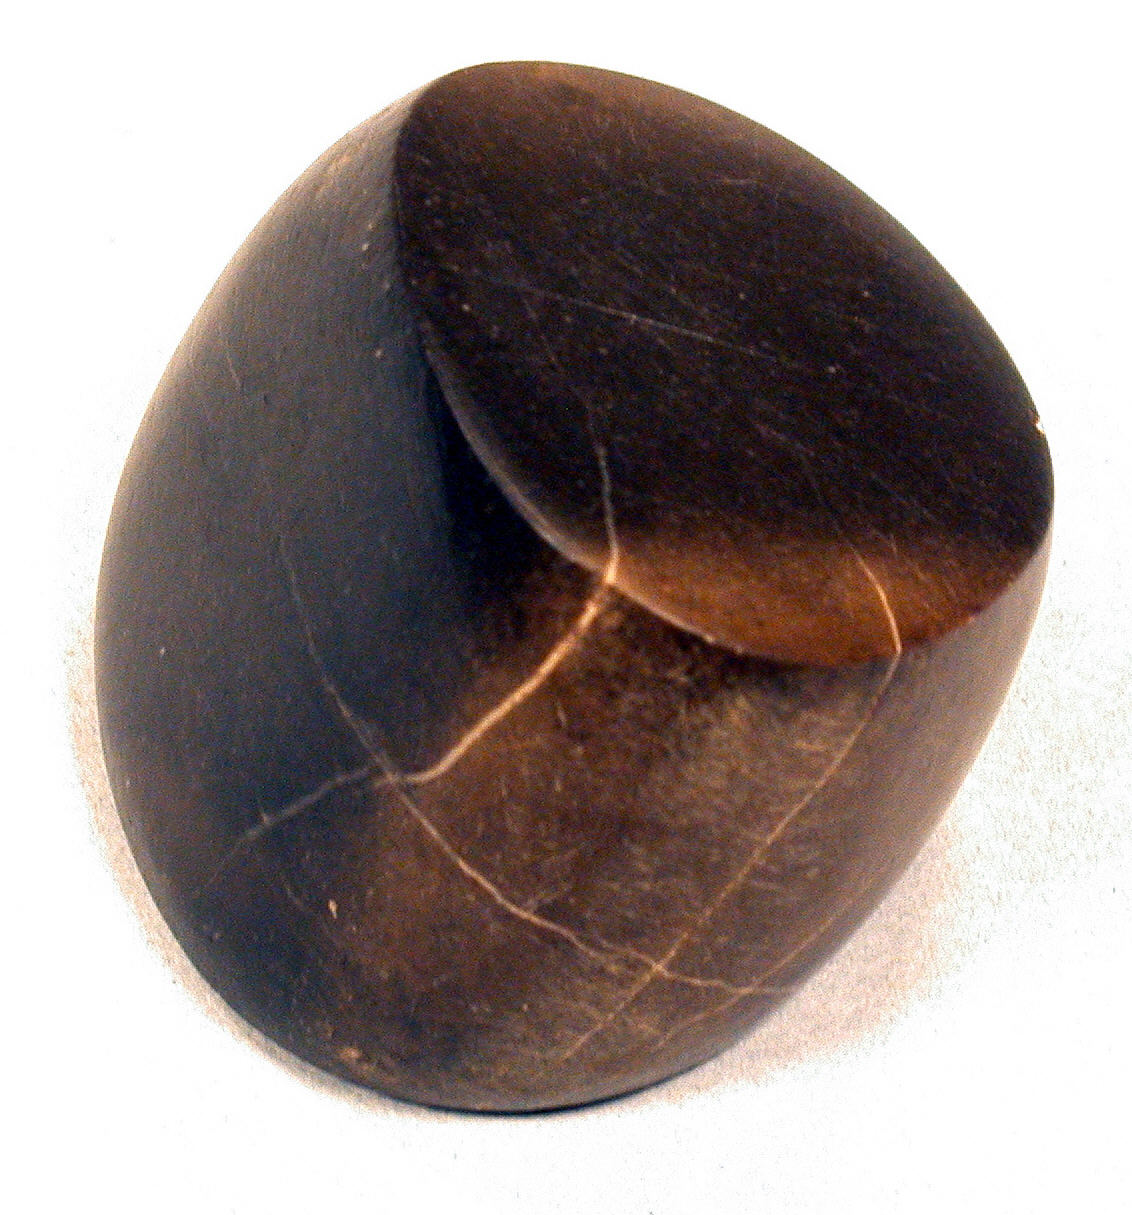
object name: ritual stone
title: Pulidor (polishing stone)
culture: mexican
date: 1501-1600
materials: stone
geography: mexico